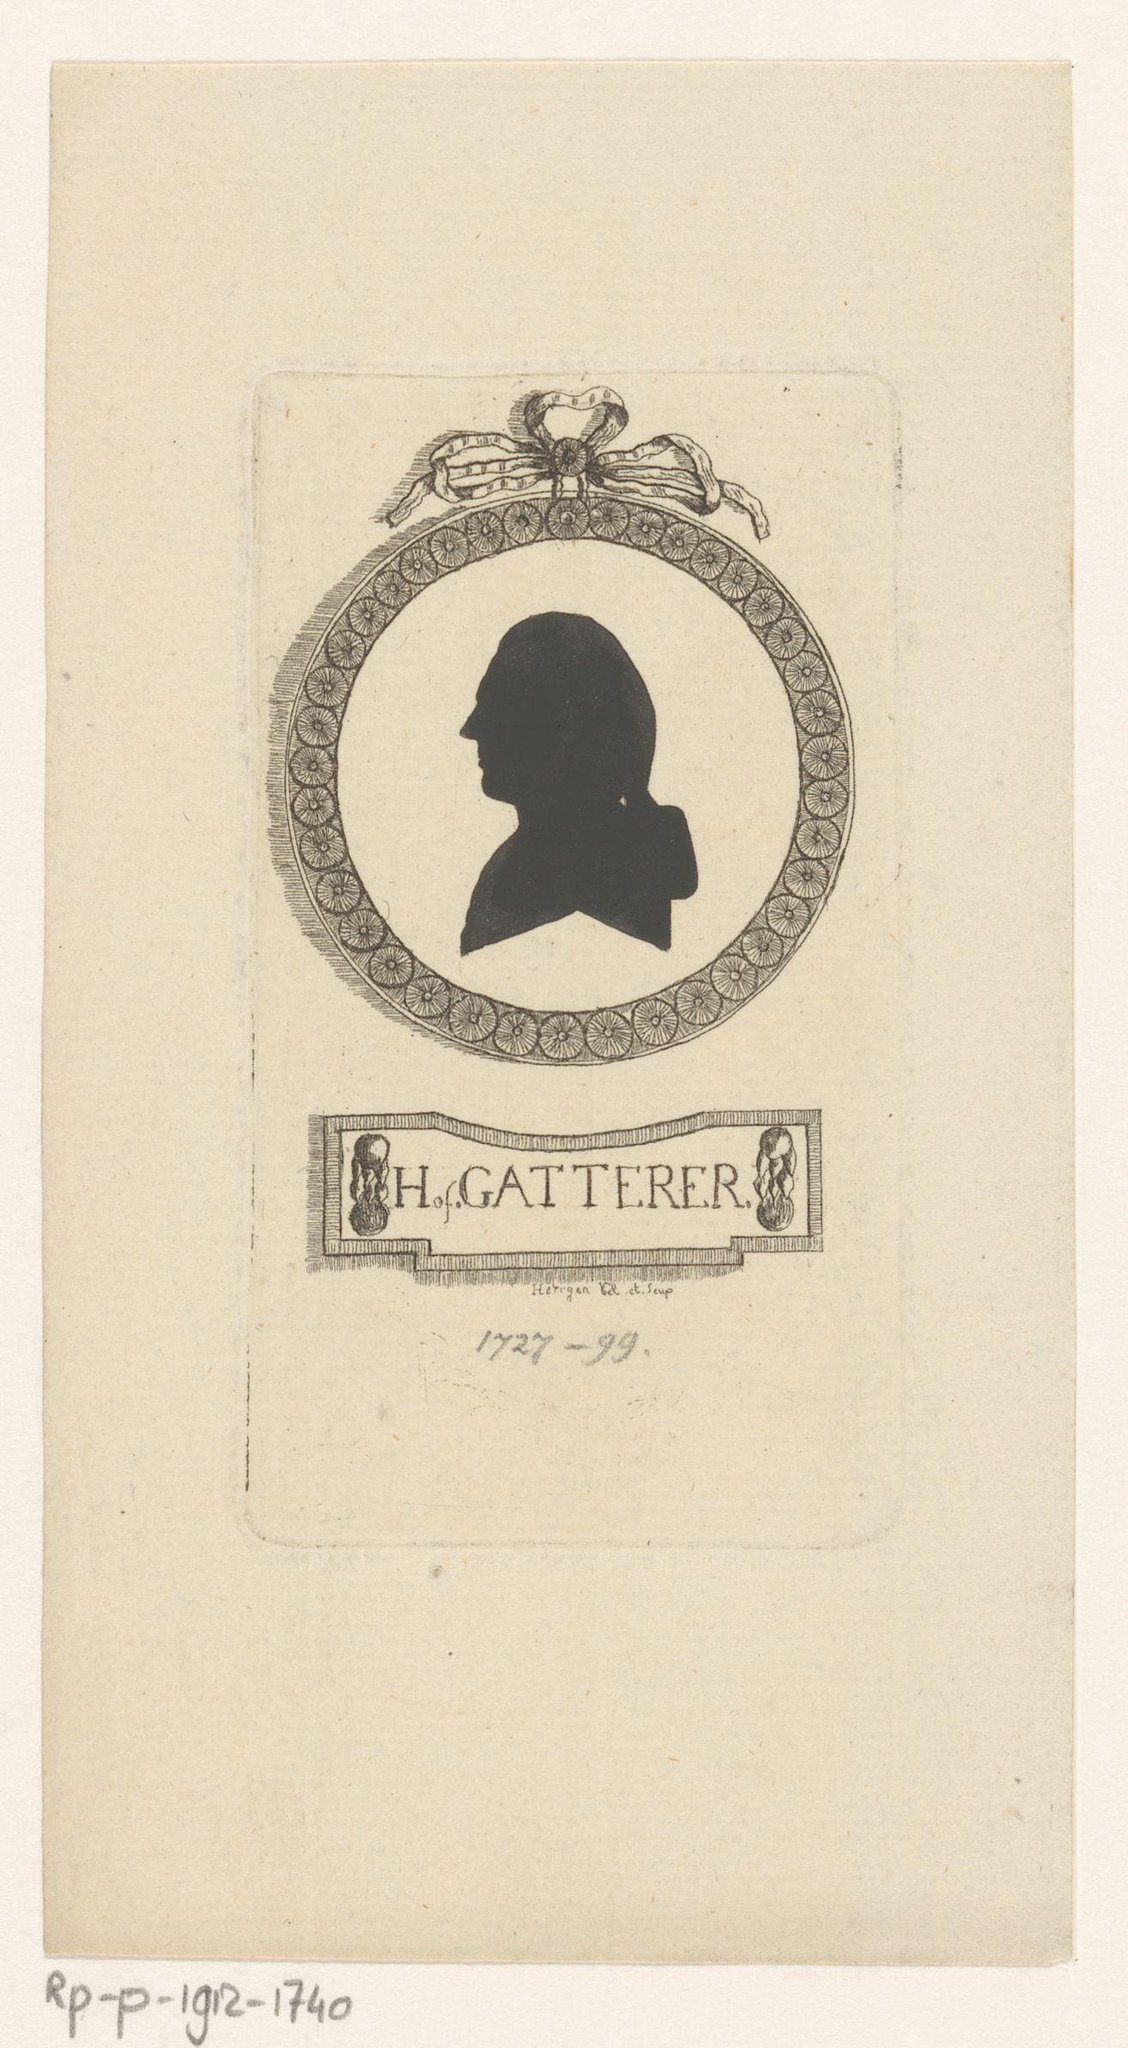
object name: print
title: Silhouetportret van Johann Christoph Gatterer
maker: herrgen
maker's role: print maker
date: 1737-1799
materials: paper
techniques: etching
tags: ornament ~ medallion, historical persons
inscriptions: collector's mark: Lugt 2228